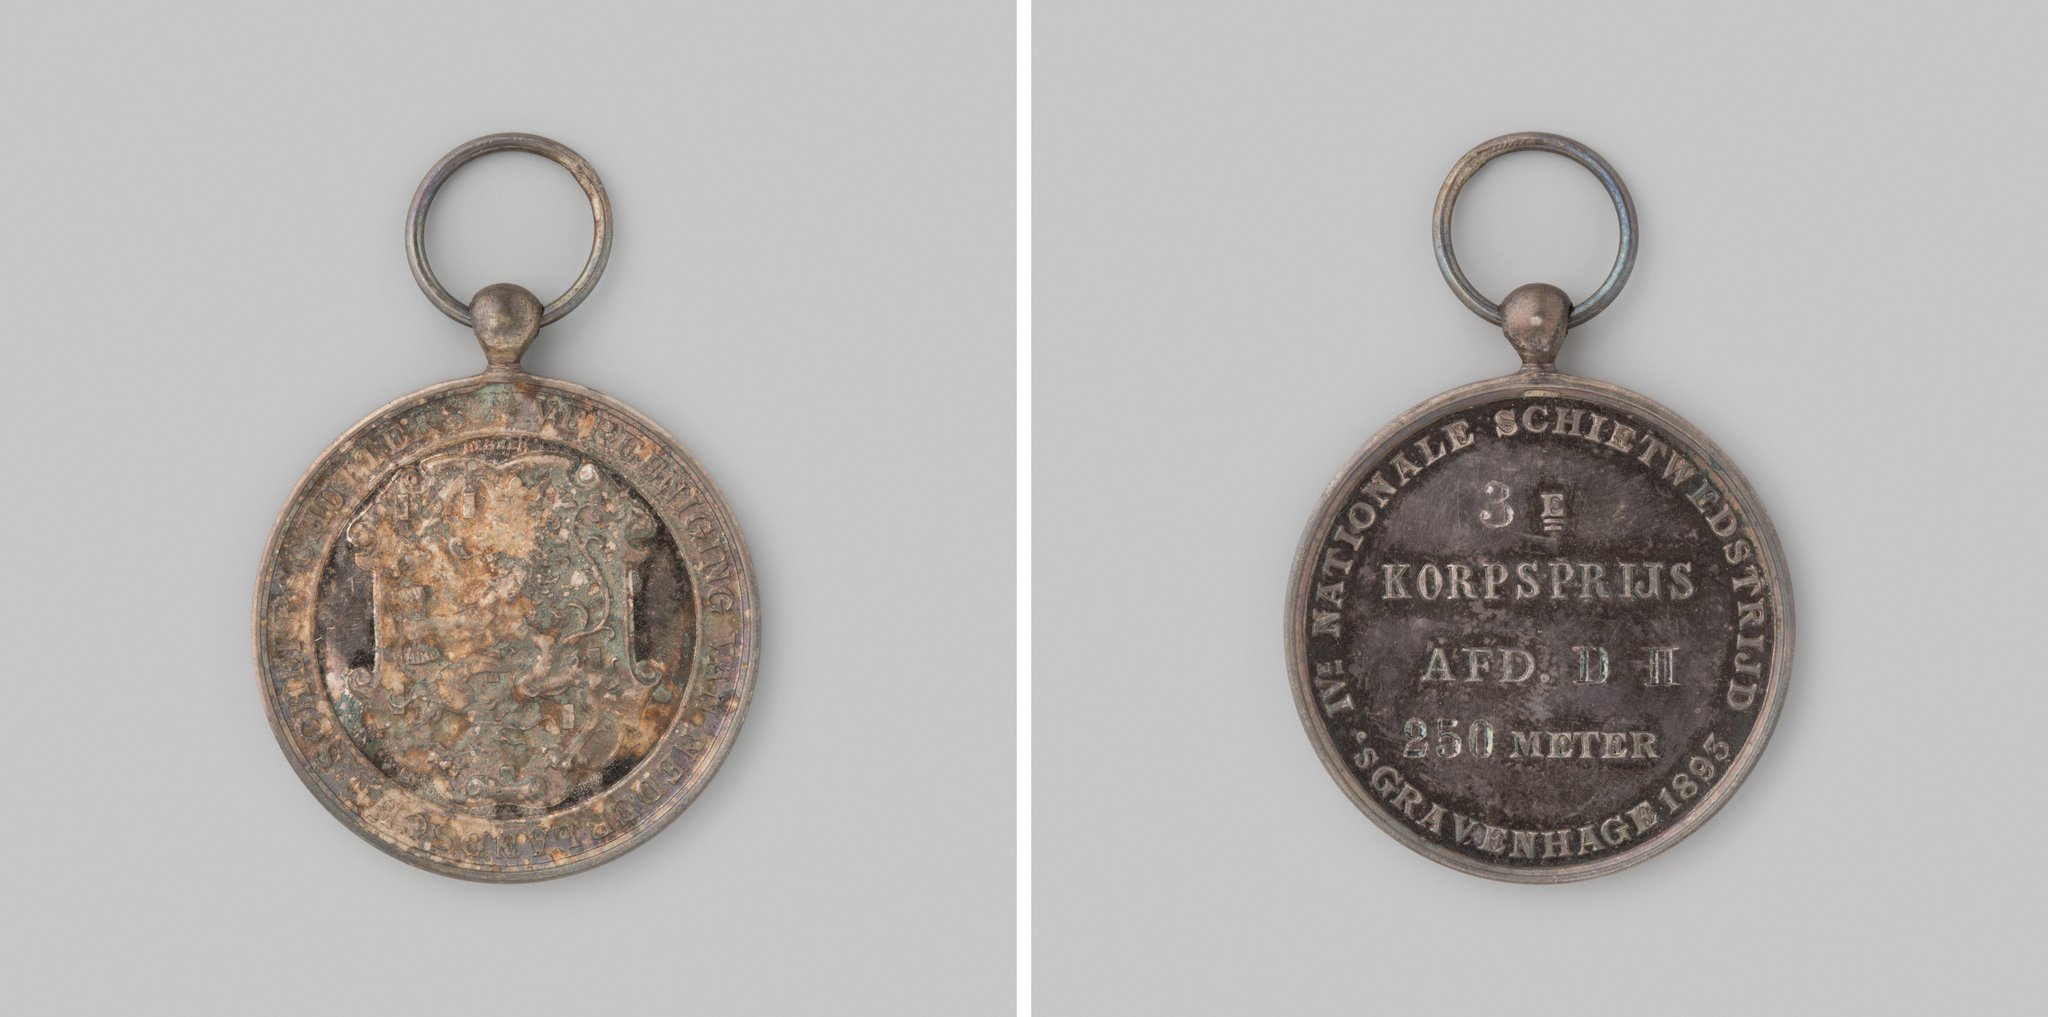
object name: draagpenning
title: Prijspenning van de Vereeniging van Nederlandsche Scherpschutters, 's Gravenhage, 1893. Salvovuur, derde prijs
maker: Anonymous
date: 1893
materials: silver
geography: amsterdam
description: Penning met ring en oog van de Vereeniging van Nederlandsche Scherpschutters, behaald door het regiment schutterij te Amsterdam, 1893. Voorzijde: wapen van Nederland in renaissancestijl. Omschrift: VERENIGING VAN NEDERLANDSCHE SCHERPSCHUTTERS. Keerzijde: ALGEMENE SCHIETWEDSTRIJD HOORN. In het veld: 3e / KORPSPRIJS / AFD D II / 250 METER. Omschrift: IVe NATIONALE SCHIETWEDSTRIJD 'S GRAVENHAGE 1893